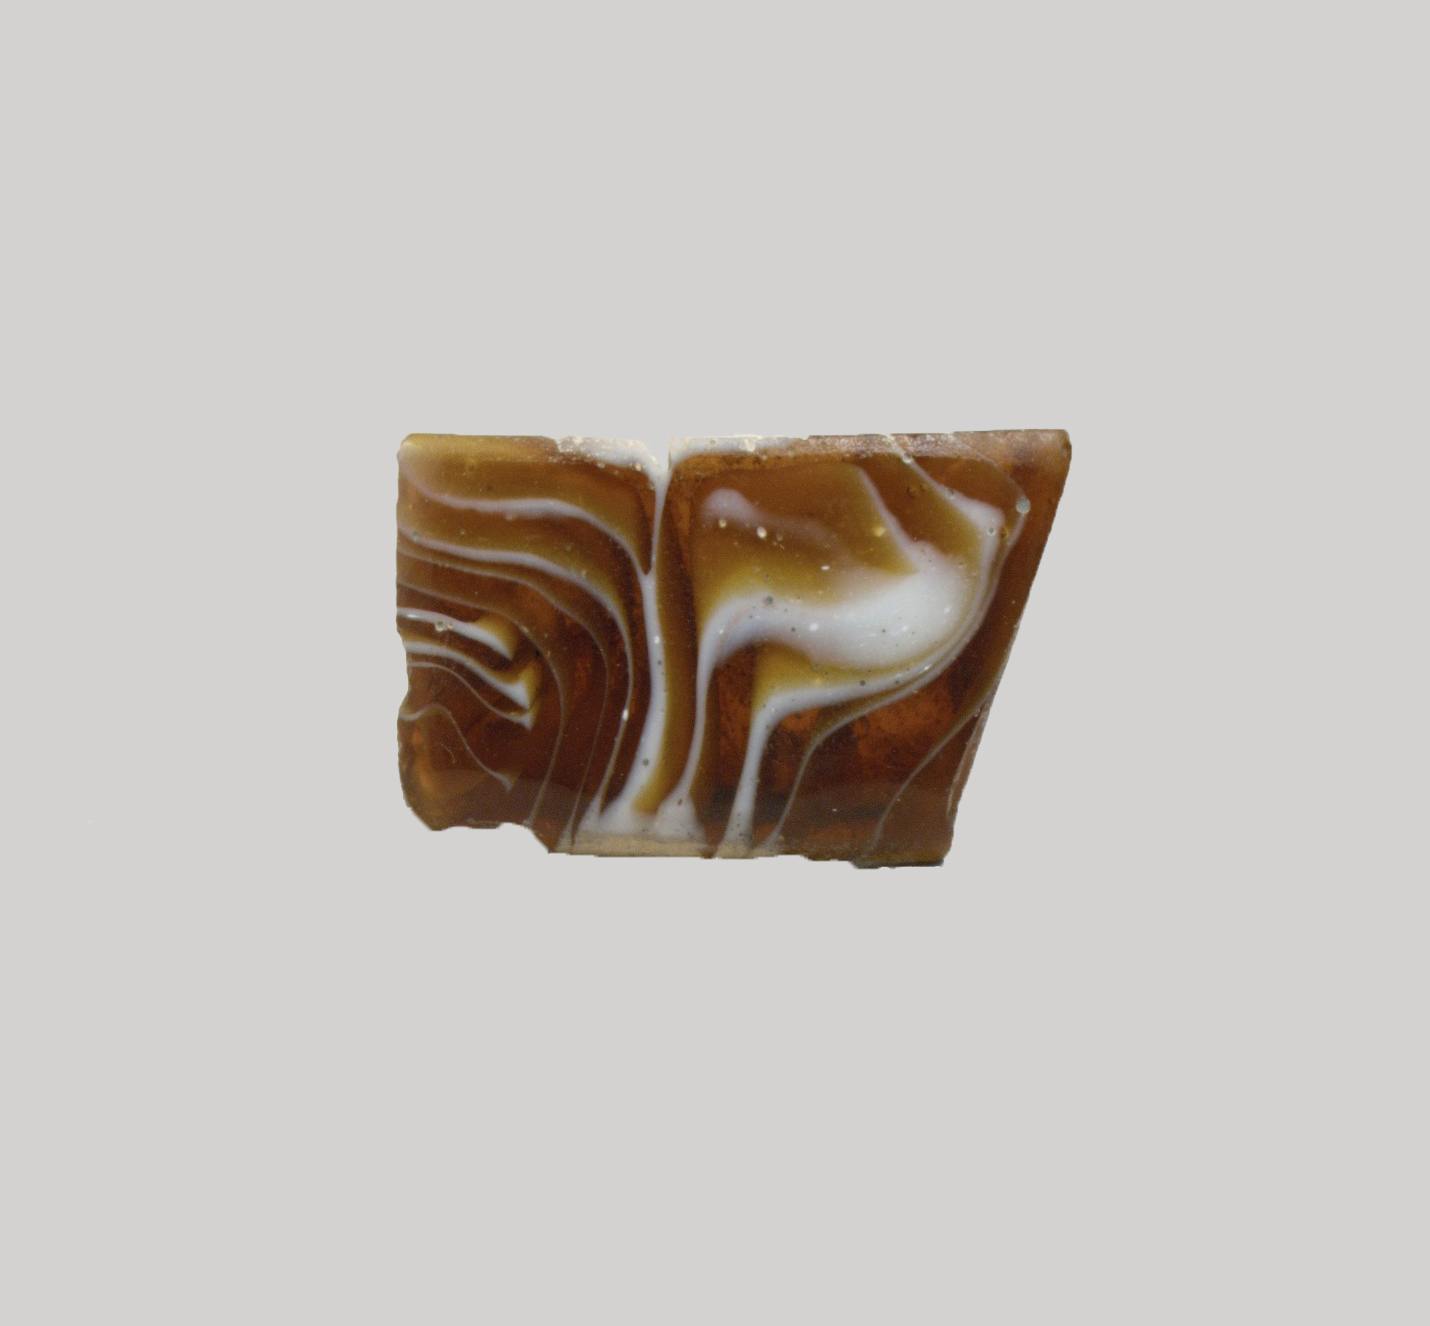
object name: fragment, mosaic dish or lid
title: Glass mosaic fragment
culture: roman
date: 34 BCE-33 CE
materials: glass